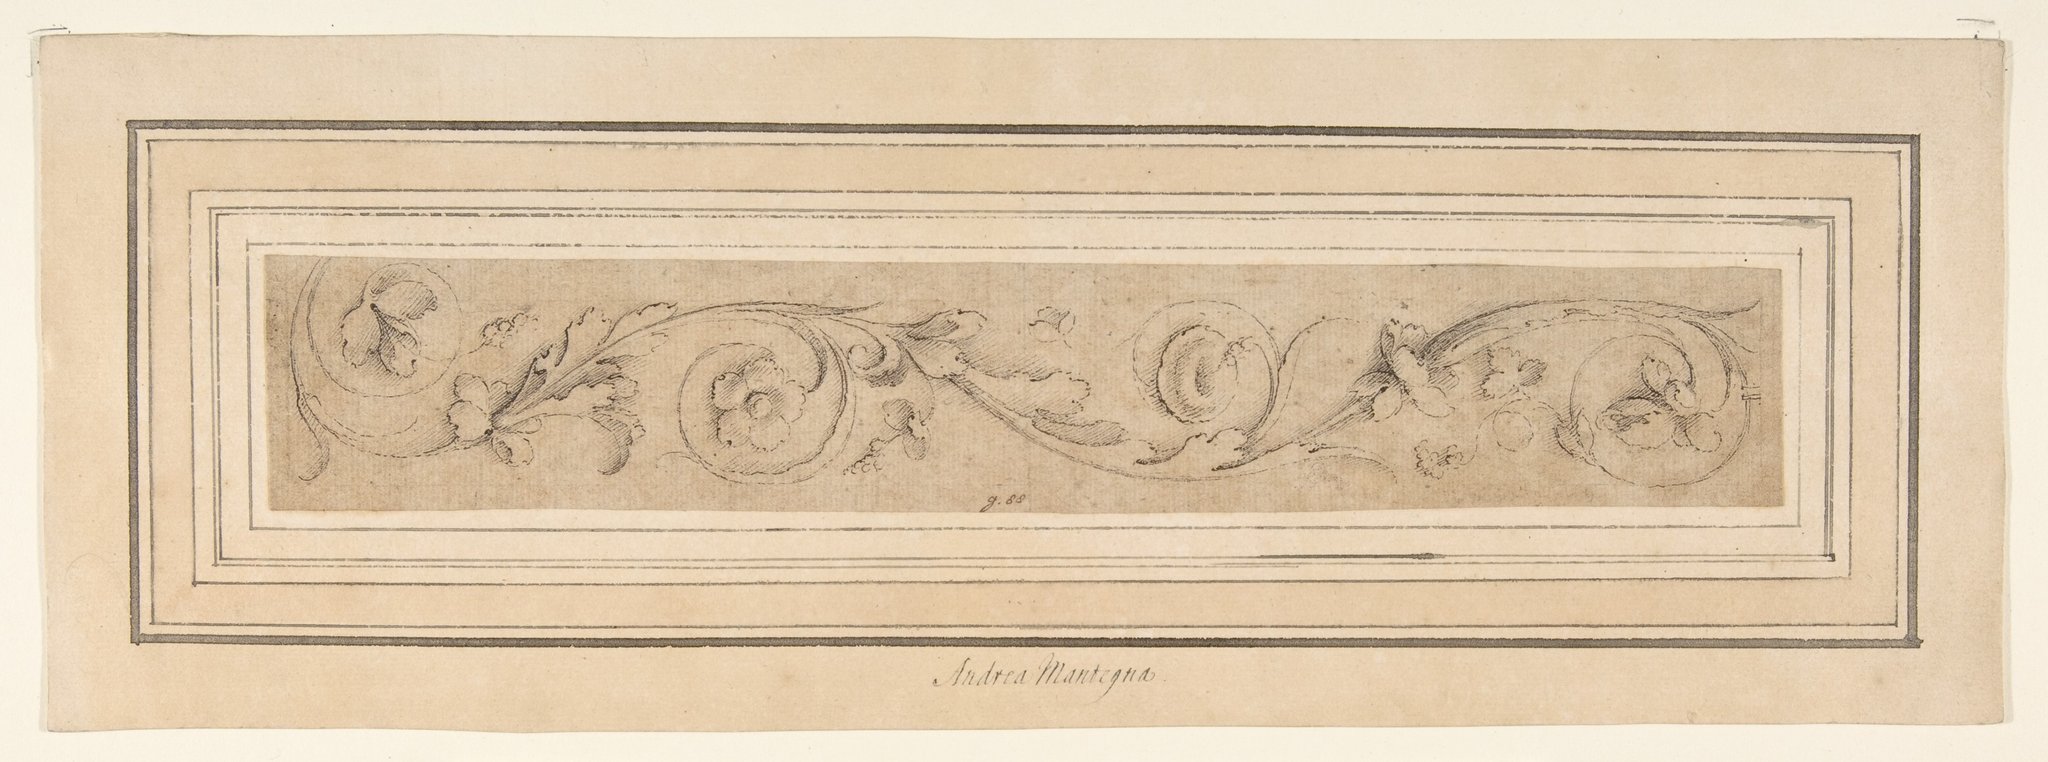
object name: drawing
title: Design of Rinceaux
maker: andrea mantegna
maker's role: artist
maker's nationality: italian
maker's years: 1431-1506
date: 1470-1510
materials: chalk, ink, drawing material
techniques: pen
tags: ornament,flowers,leaves